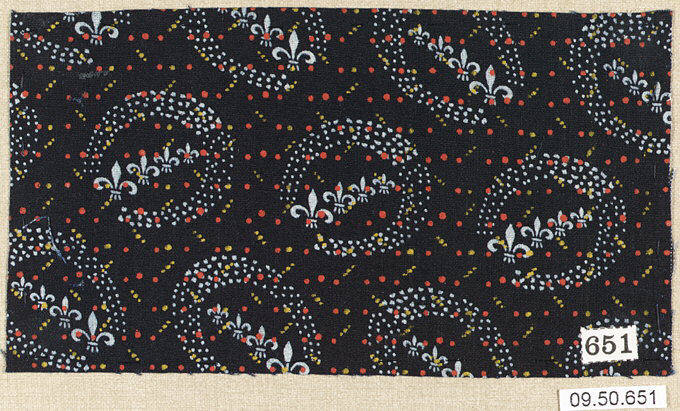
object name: piece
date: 1801-1900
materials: cotton